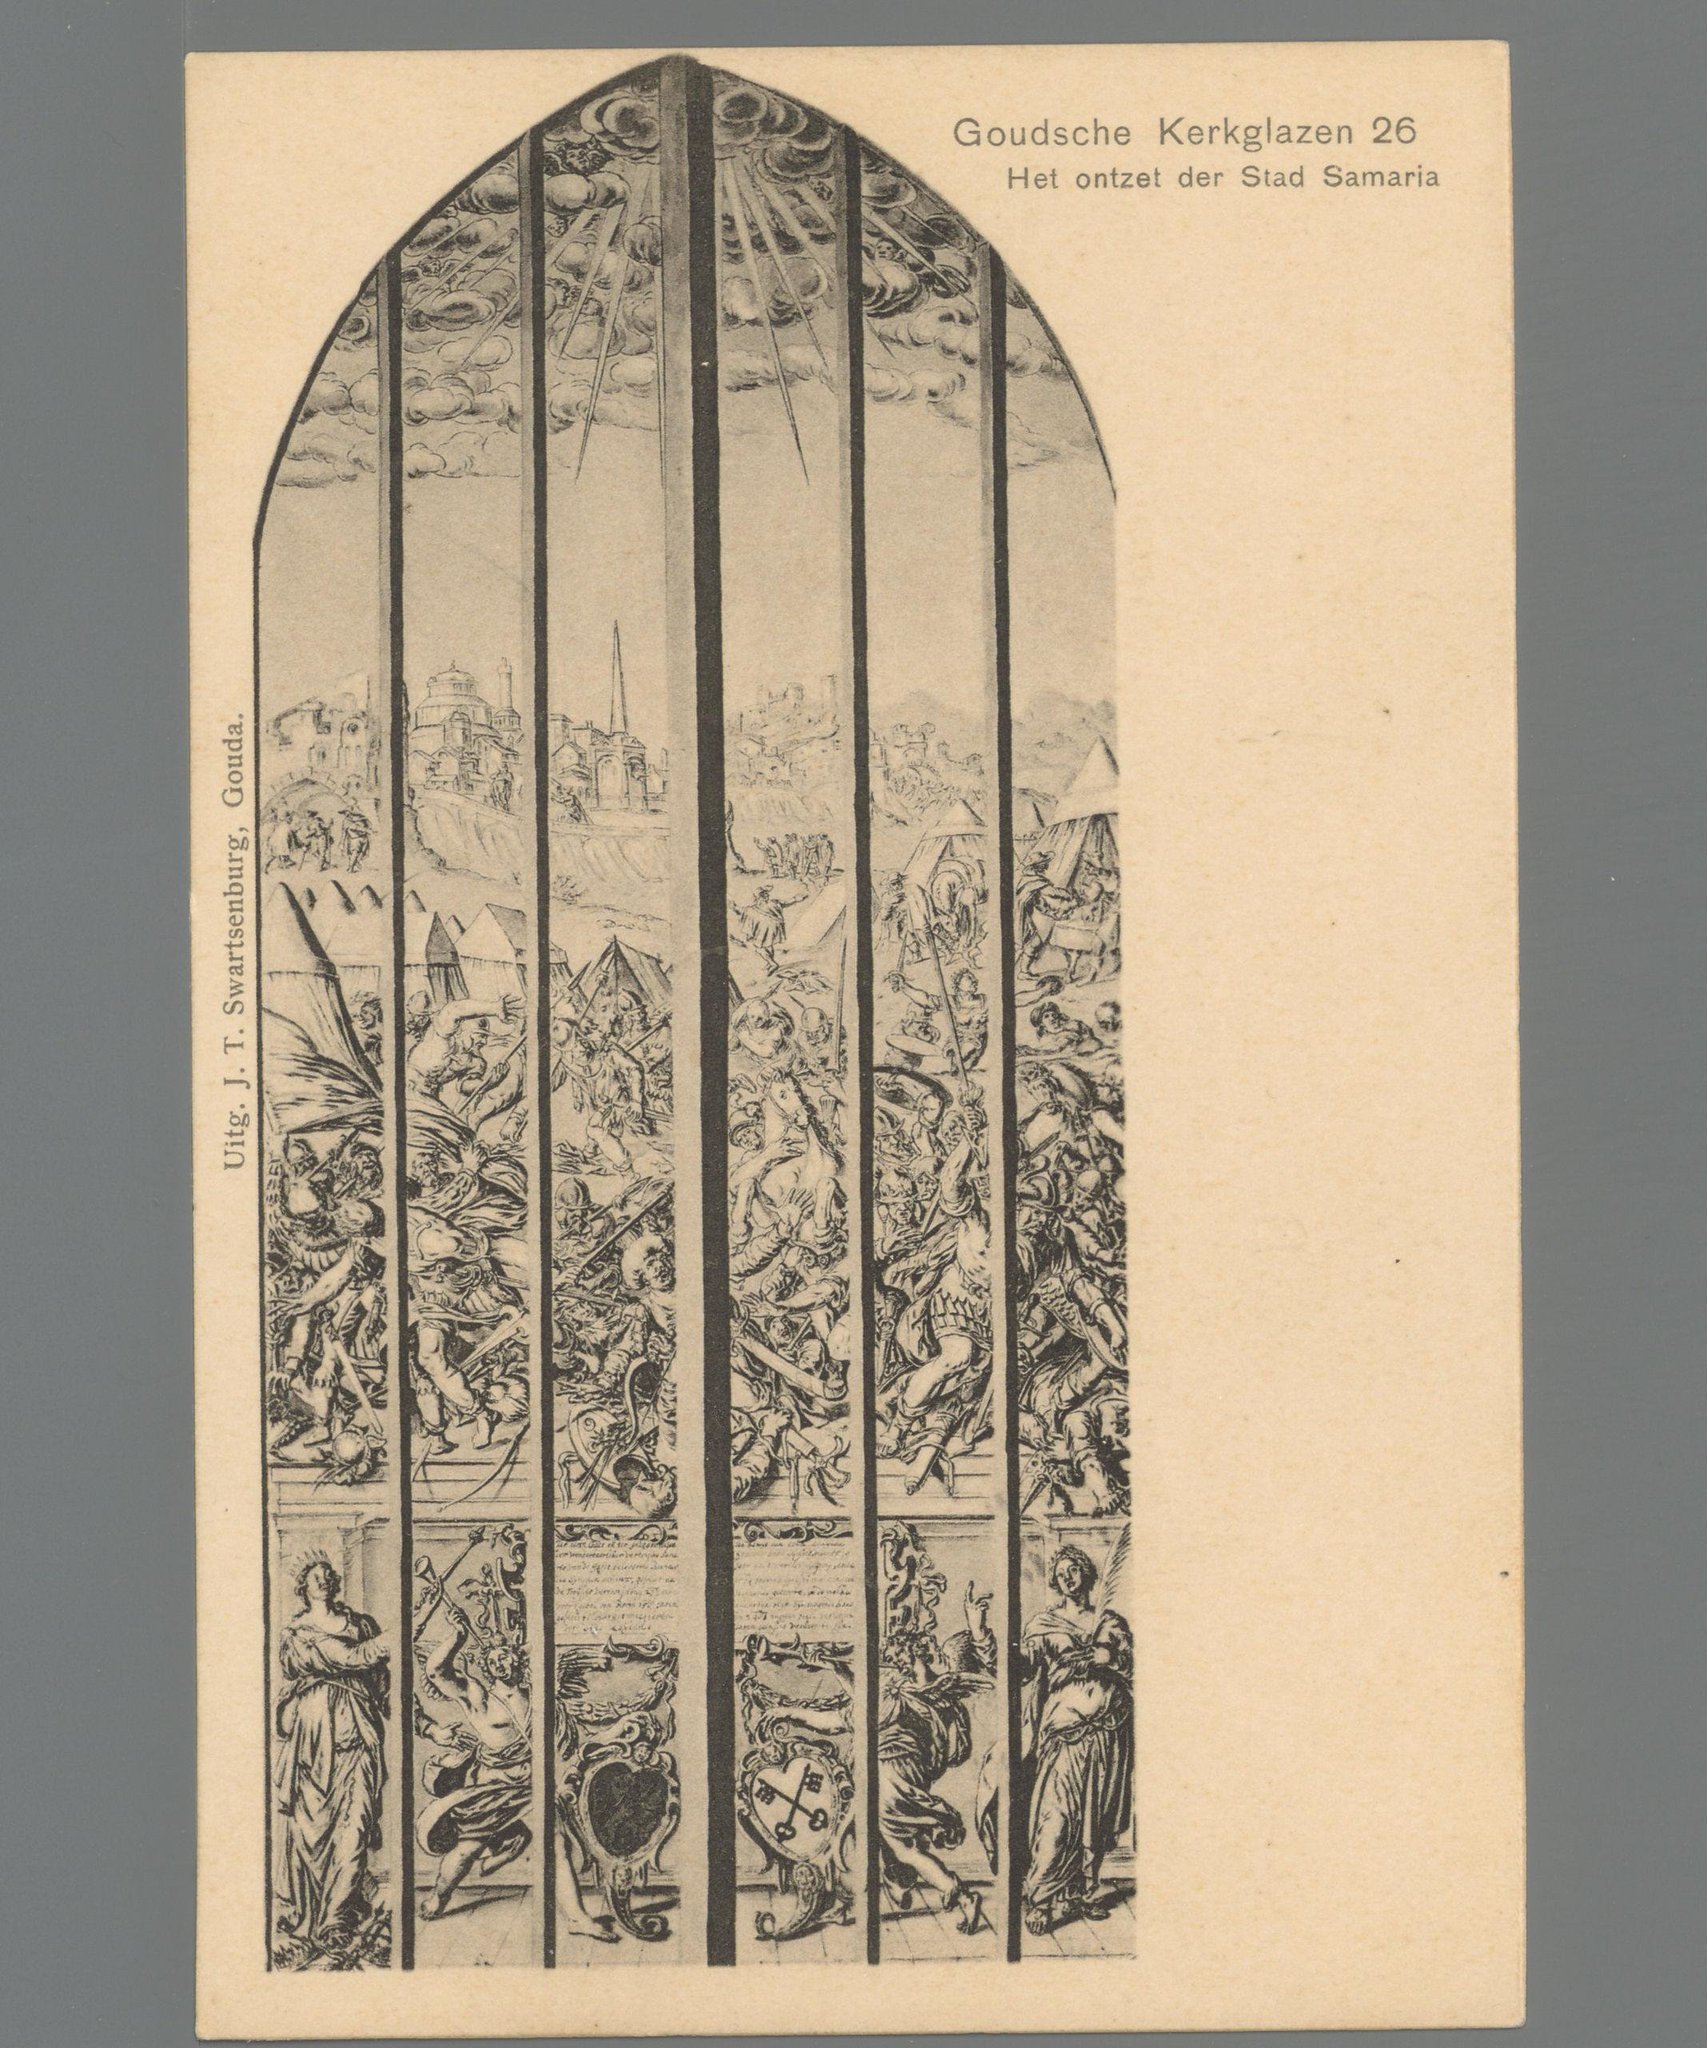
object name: ansichtkaart, prentbriefkaart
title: Goudsche Kerkglazen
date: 1892-1905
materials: cardboard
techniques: photograph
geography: gouda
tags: church-window, e.g. rose-window, the fall of samaria (2 kings 17:5-6), gouda